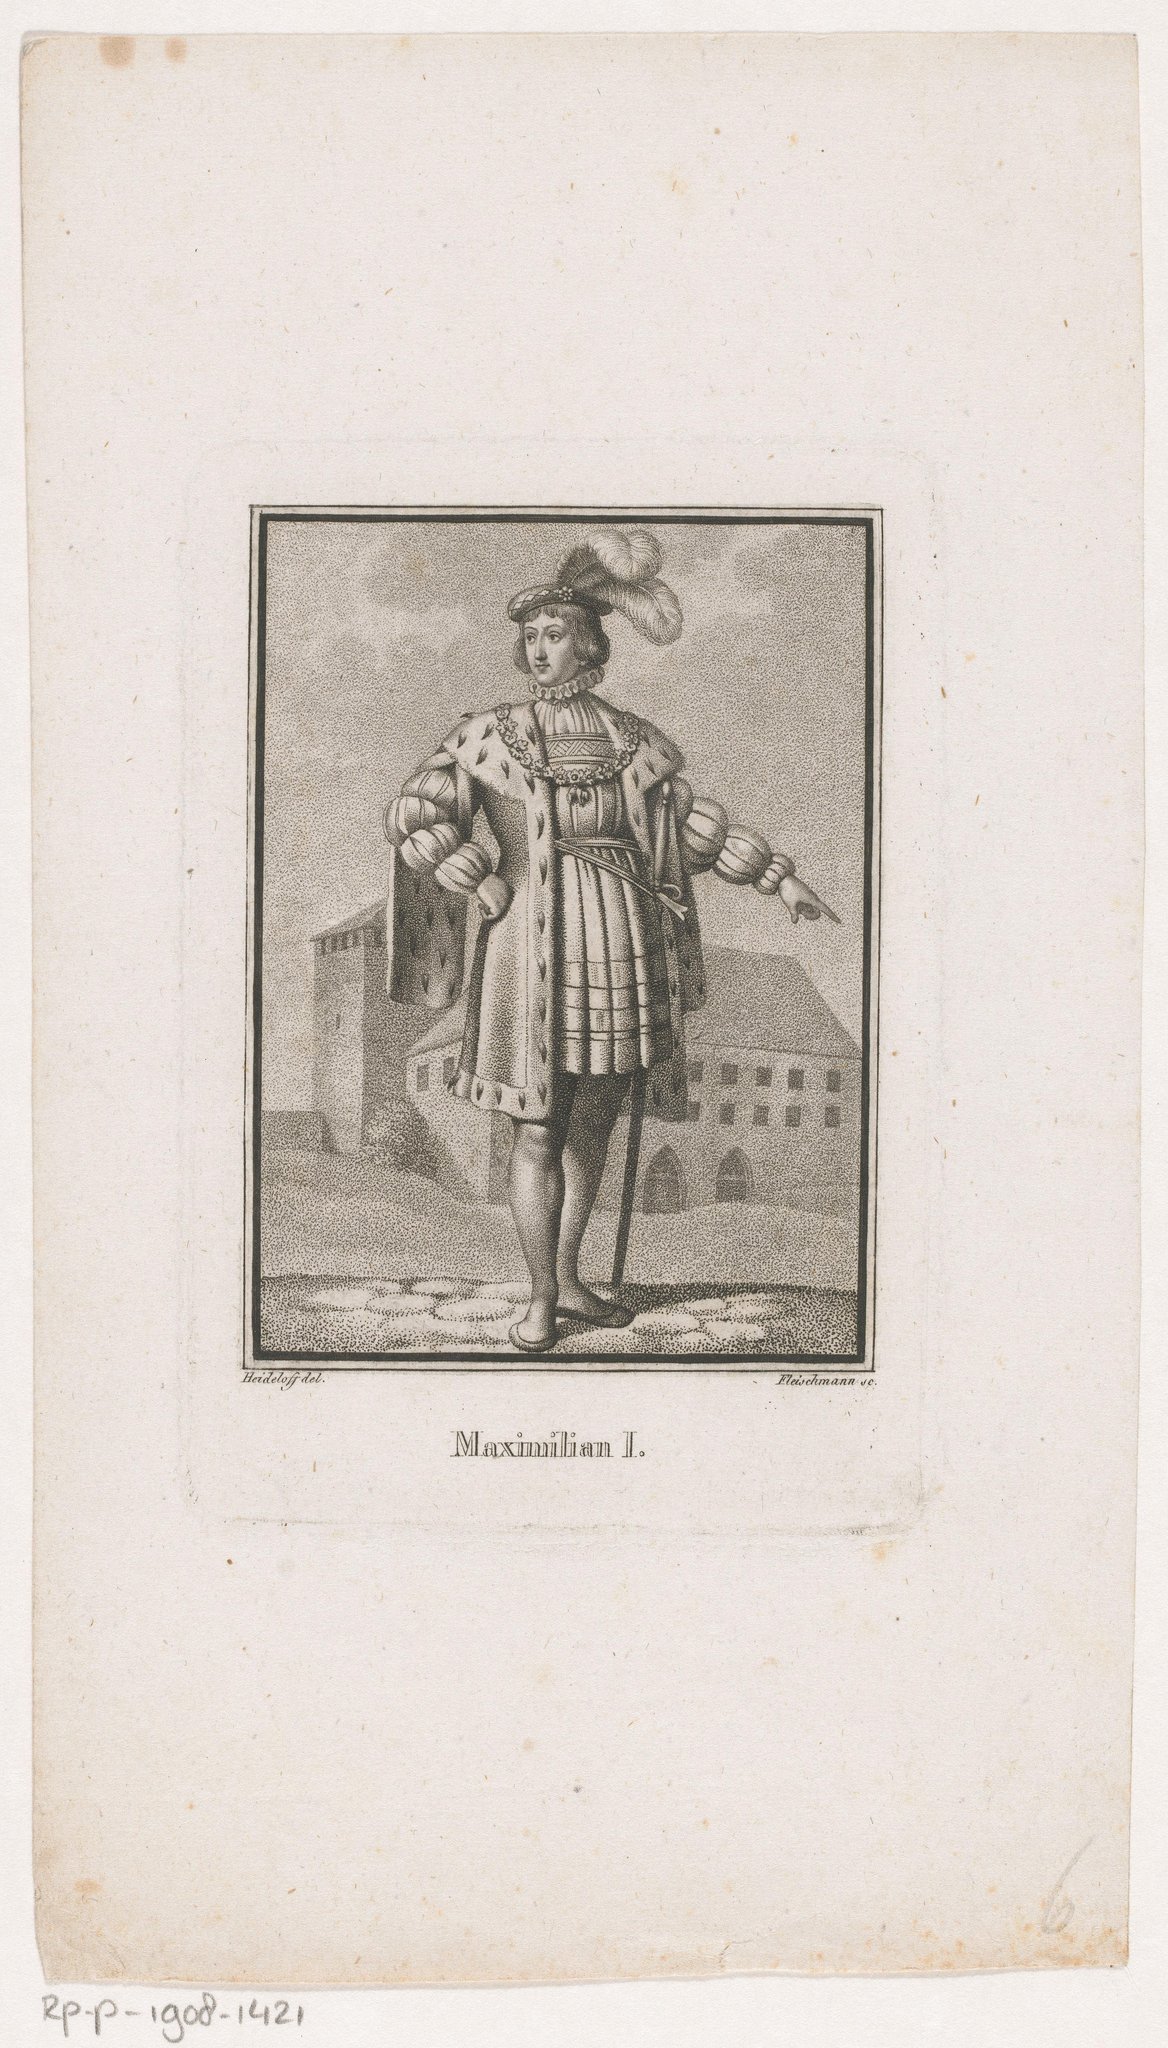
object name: book illustration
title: Portret van keizer Maximiliaan I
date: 1821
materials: paper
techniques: stippling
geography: nuremberg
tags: maximilian i (holy roman emperor), historical persons, emperor, ruler, sovereign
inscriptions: collector's mark: Lugt 2228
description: Prent gebruikt voor: Jerrer, Georg Ludwig. Geschichte der Teutschen für die Jugend (...). Neurenberg: Friedrich Campe, 1821.